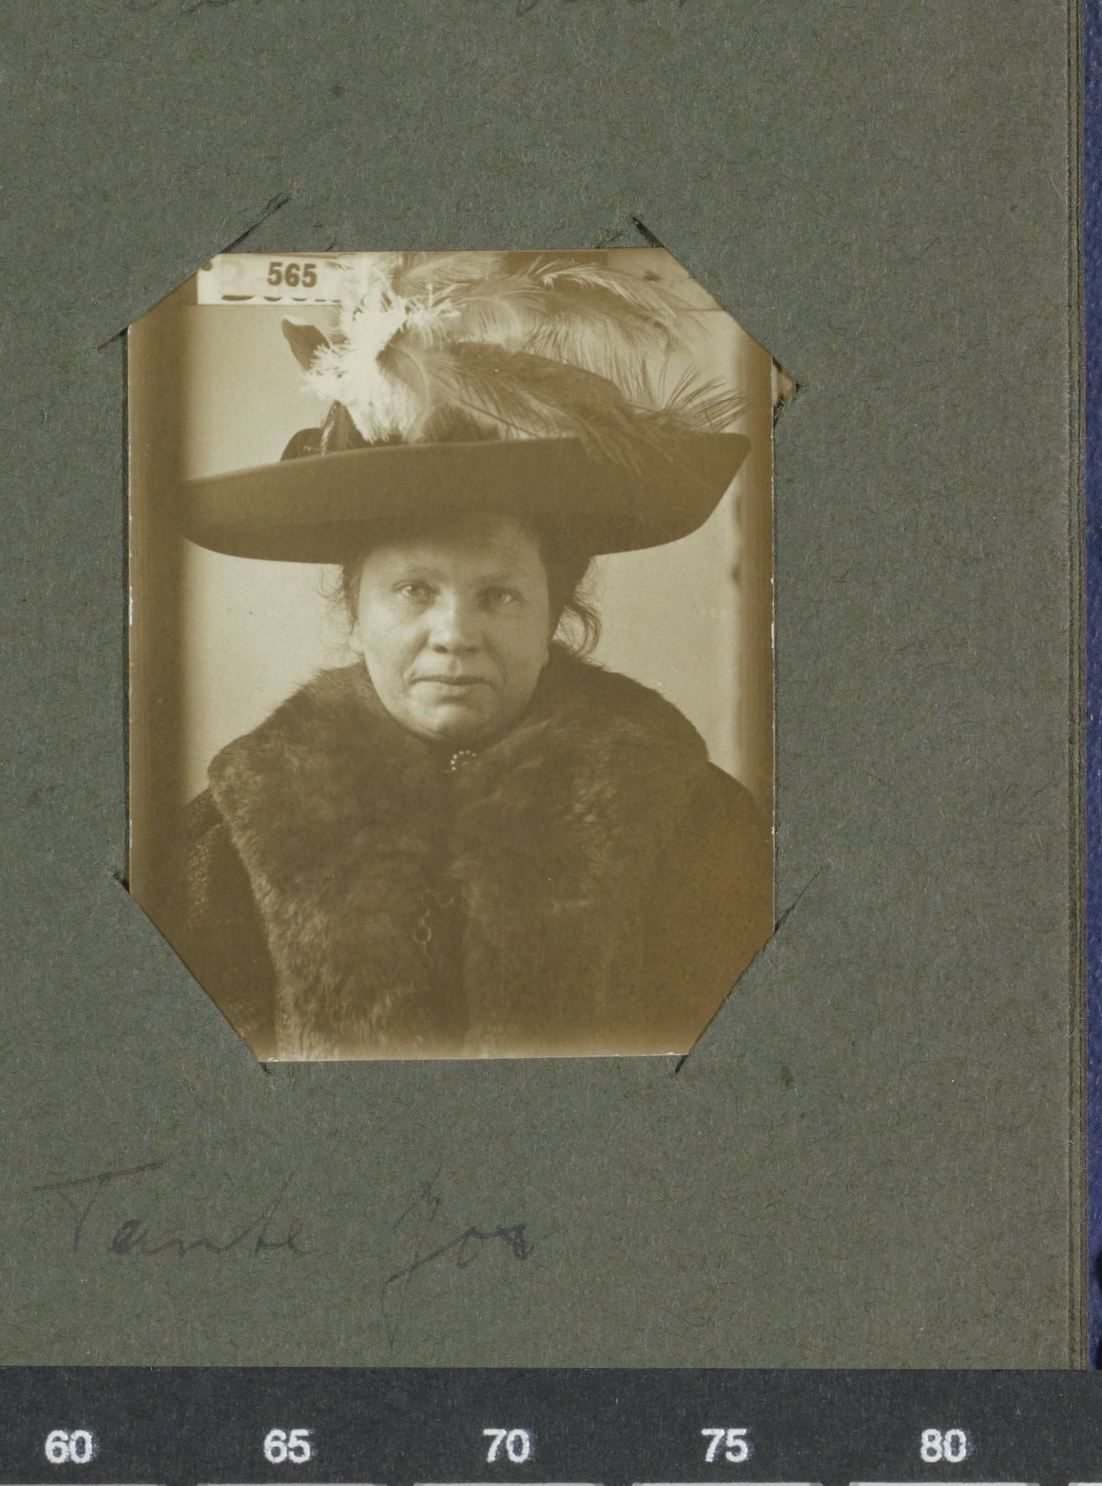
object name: photograph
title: Portret van een vrouw met een hoed, aangeduid als 'Tante Jos'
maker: Anonymous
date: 1910-1920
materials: cardboard, paper, photographic support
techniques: gelatin silver print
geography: netherlands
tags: adult woman, historical persons, head-gear: hat, netherlands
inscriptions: number: ‘565’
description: Onderdeel van Album met automaatfoto's van een Nederlandse familie.